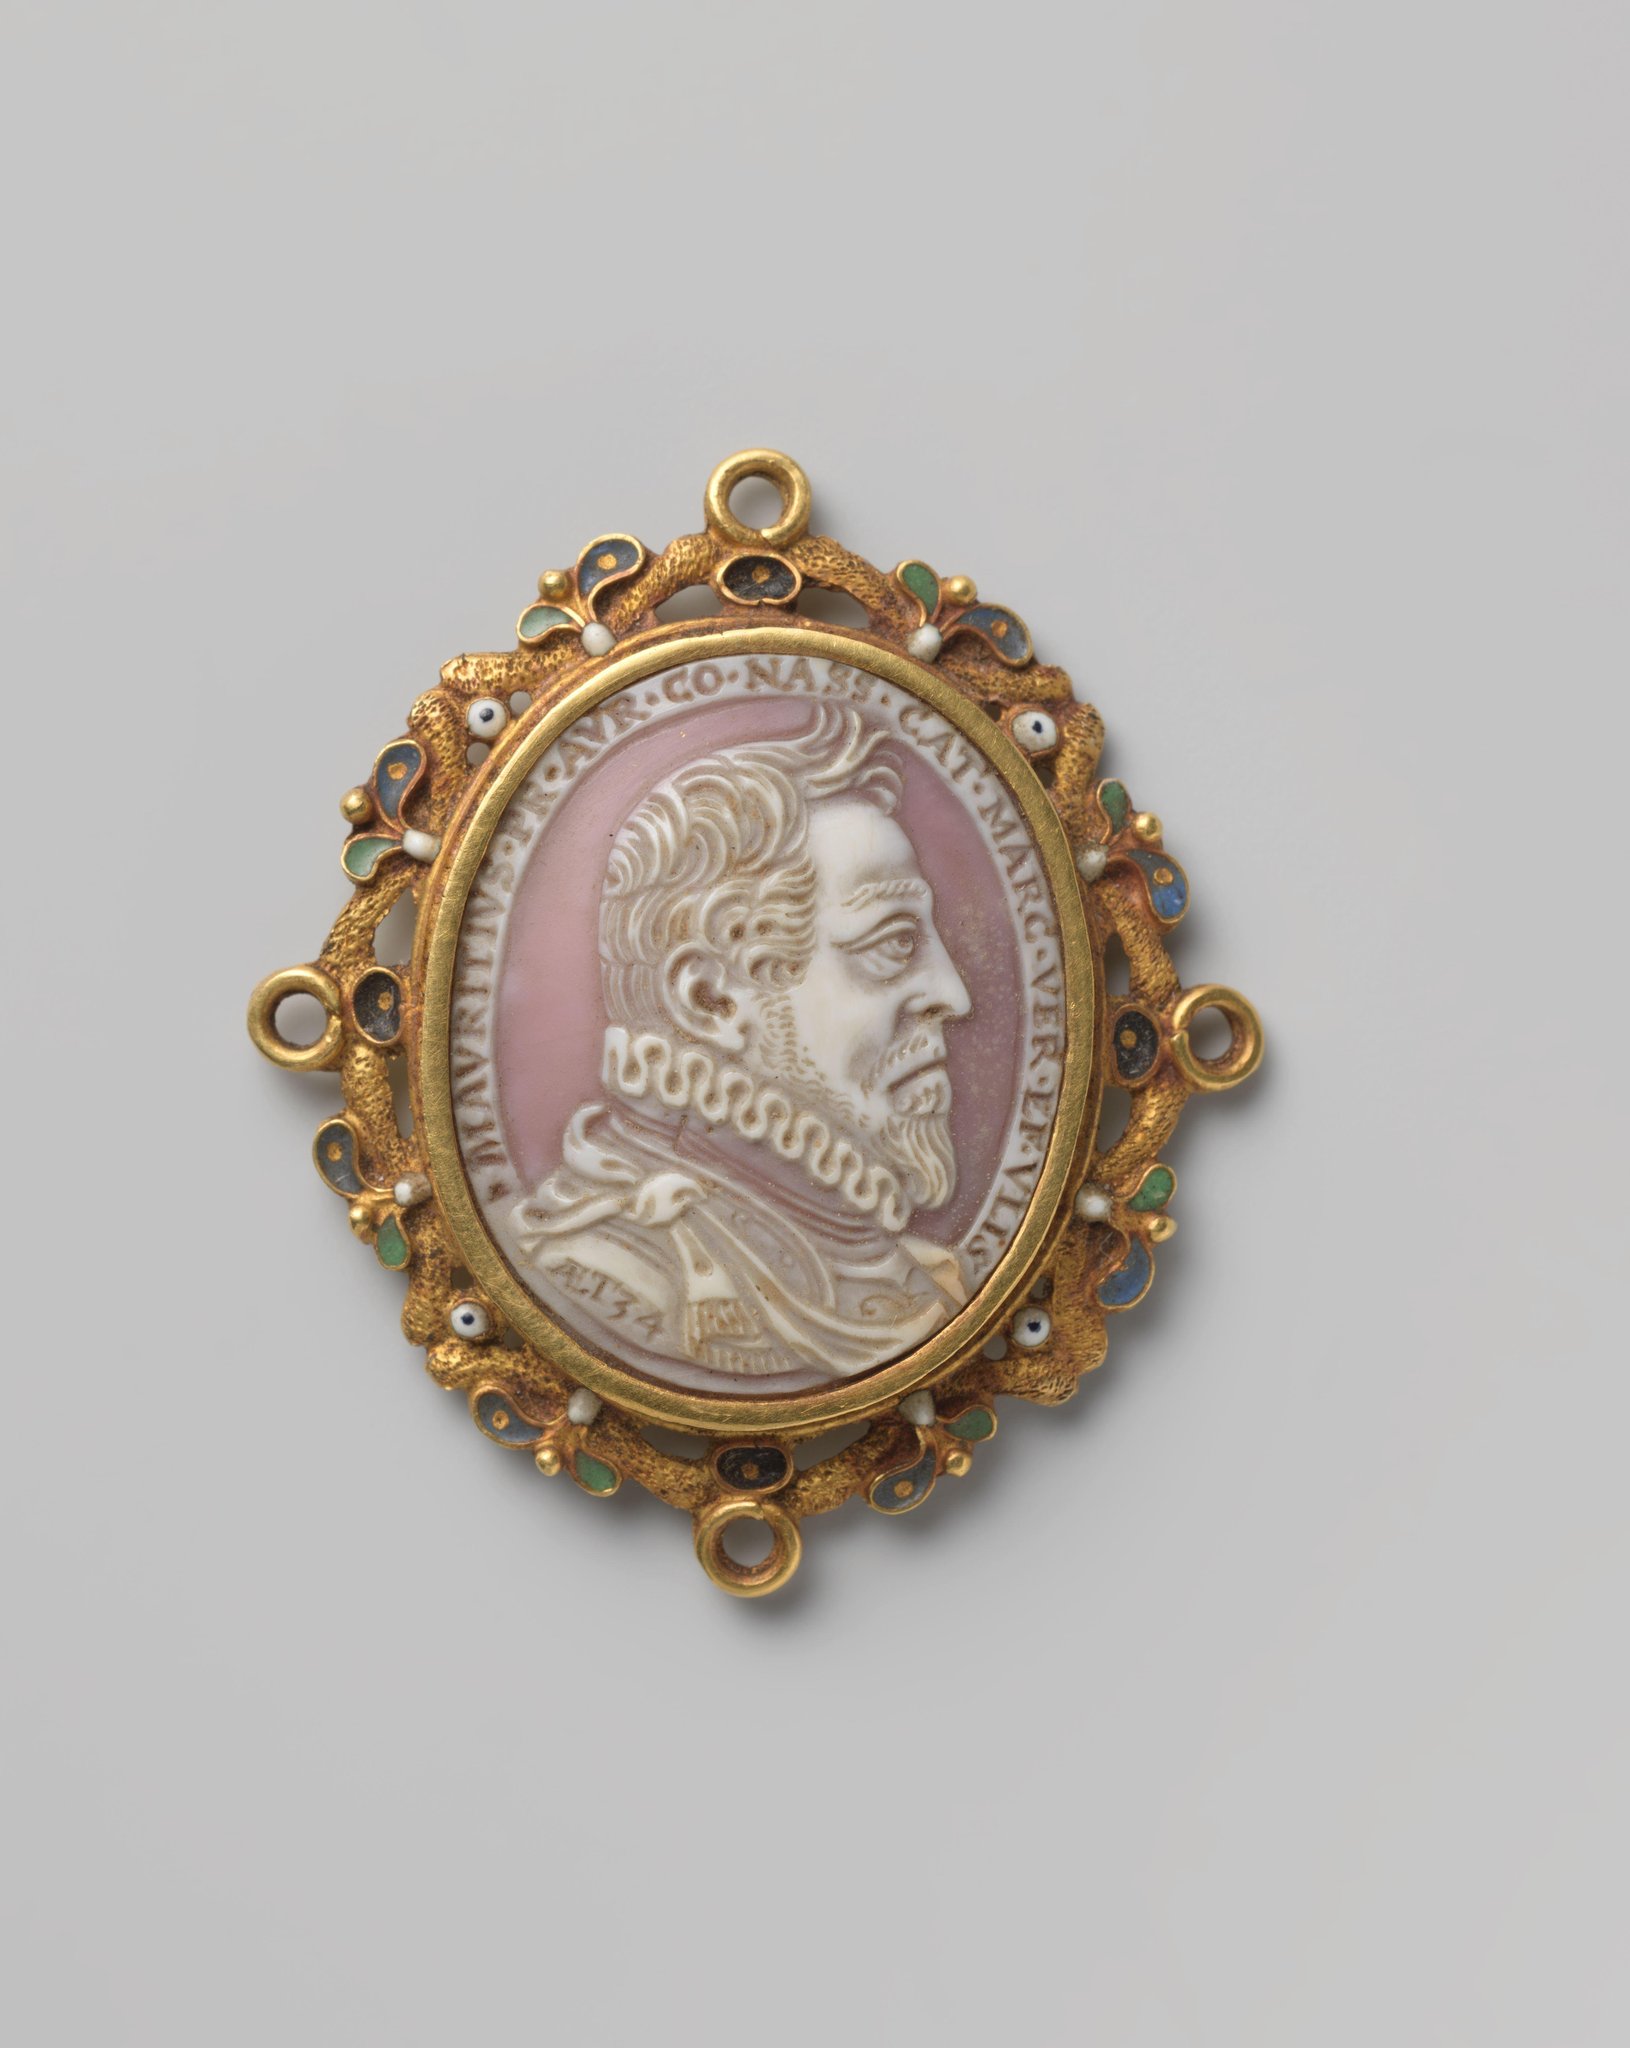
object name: portretmedaillon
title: Hanger met portret van prins Maurits van Nassau (1567-1625)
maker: Anonymous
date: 1602-1620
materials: gold, shell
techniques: cutting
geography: netherlands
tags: the hague, maurice (prince of orange)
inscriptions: edge inscription: ‘MAVRITVS. PR AVR, Co. NASS CAT. MARC. VER. ET VLLS. AE 34’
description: Portret van prins Maurits van Nassau (1567-1625), prins van Oranje, Stadhouder. Gesneden schelp (camee van Cypraea tigris), wit op paarse grond. Opschrift camee (rand): MAVRITIVS PR AVR CO NASS CAT MARC VER ET VLIS (Maurits, prins van Oranje, graaf van Nassau en Katzenelnbogen, markies van Veere en Vlissingen). Opschrift camee (schouder Maurits): AET 34. In een bewerkte gouden lijst met geëmailleerde bloemen en vier oogjes, bestemd om als medaillon gedragen te worden.